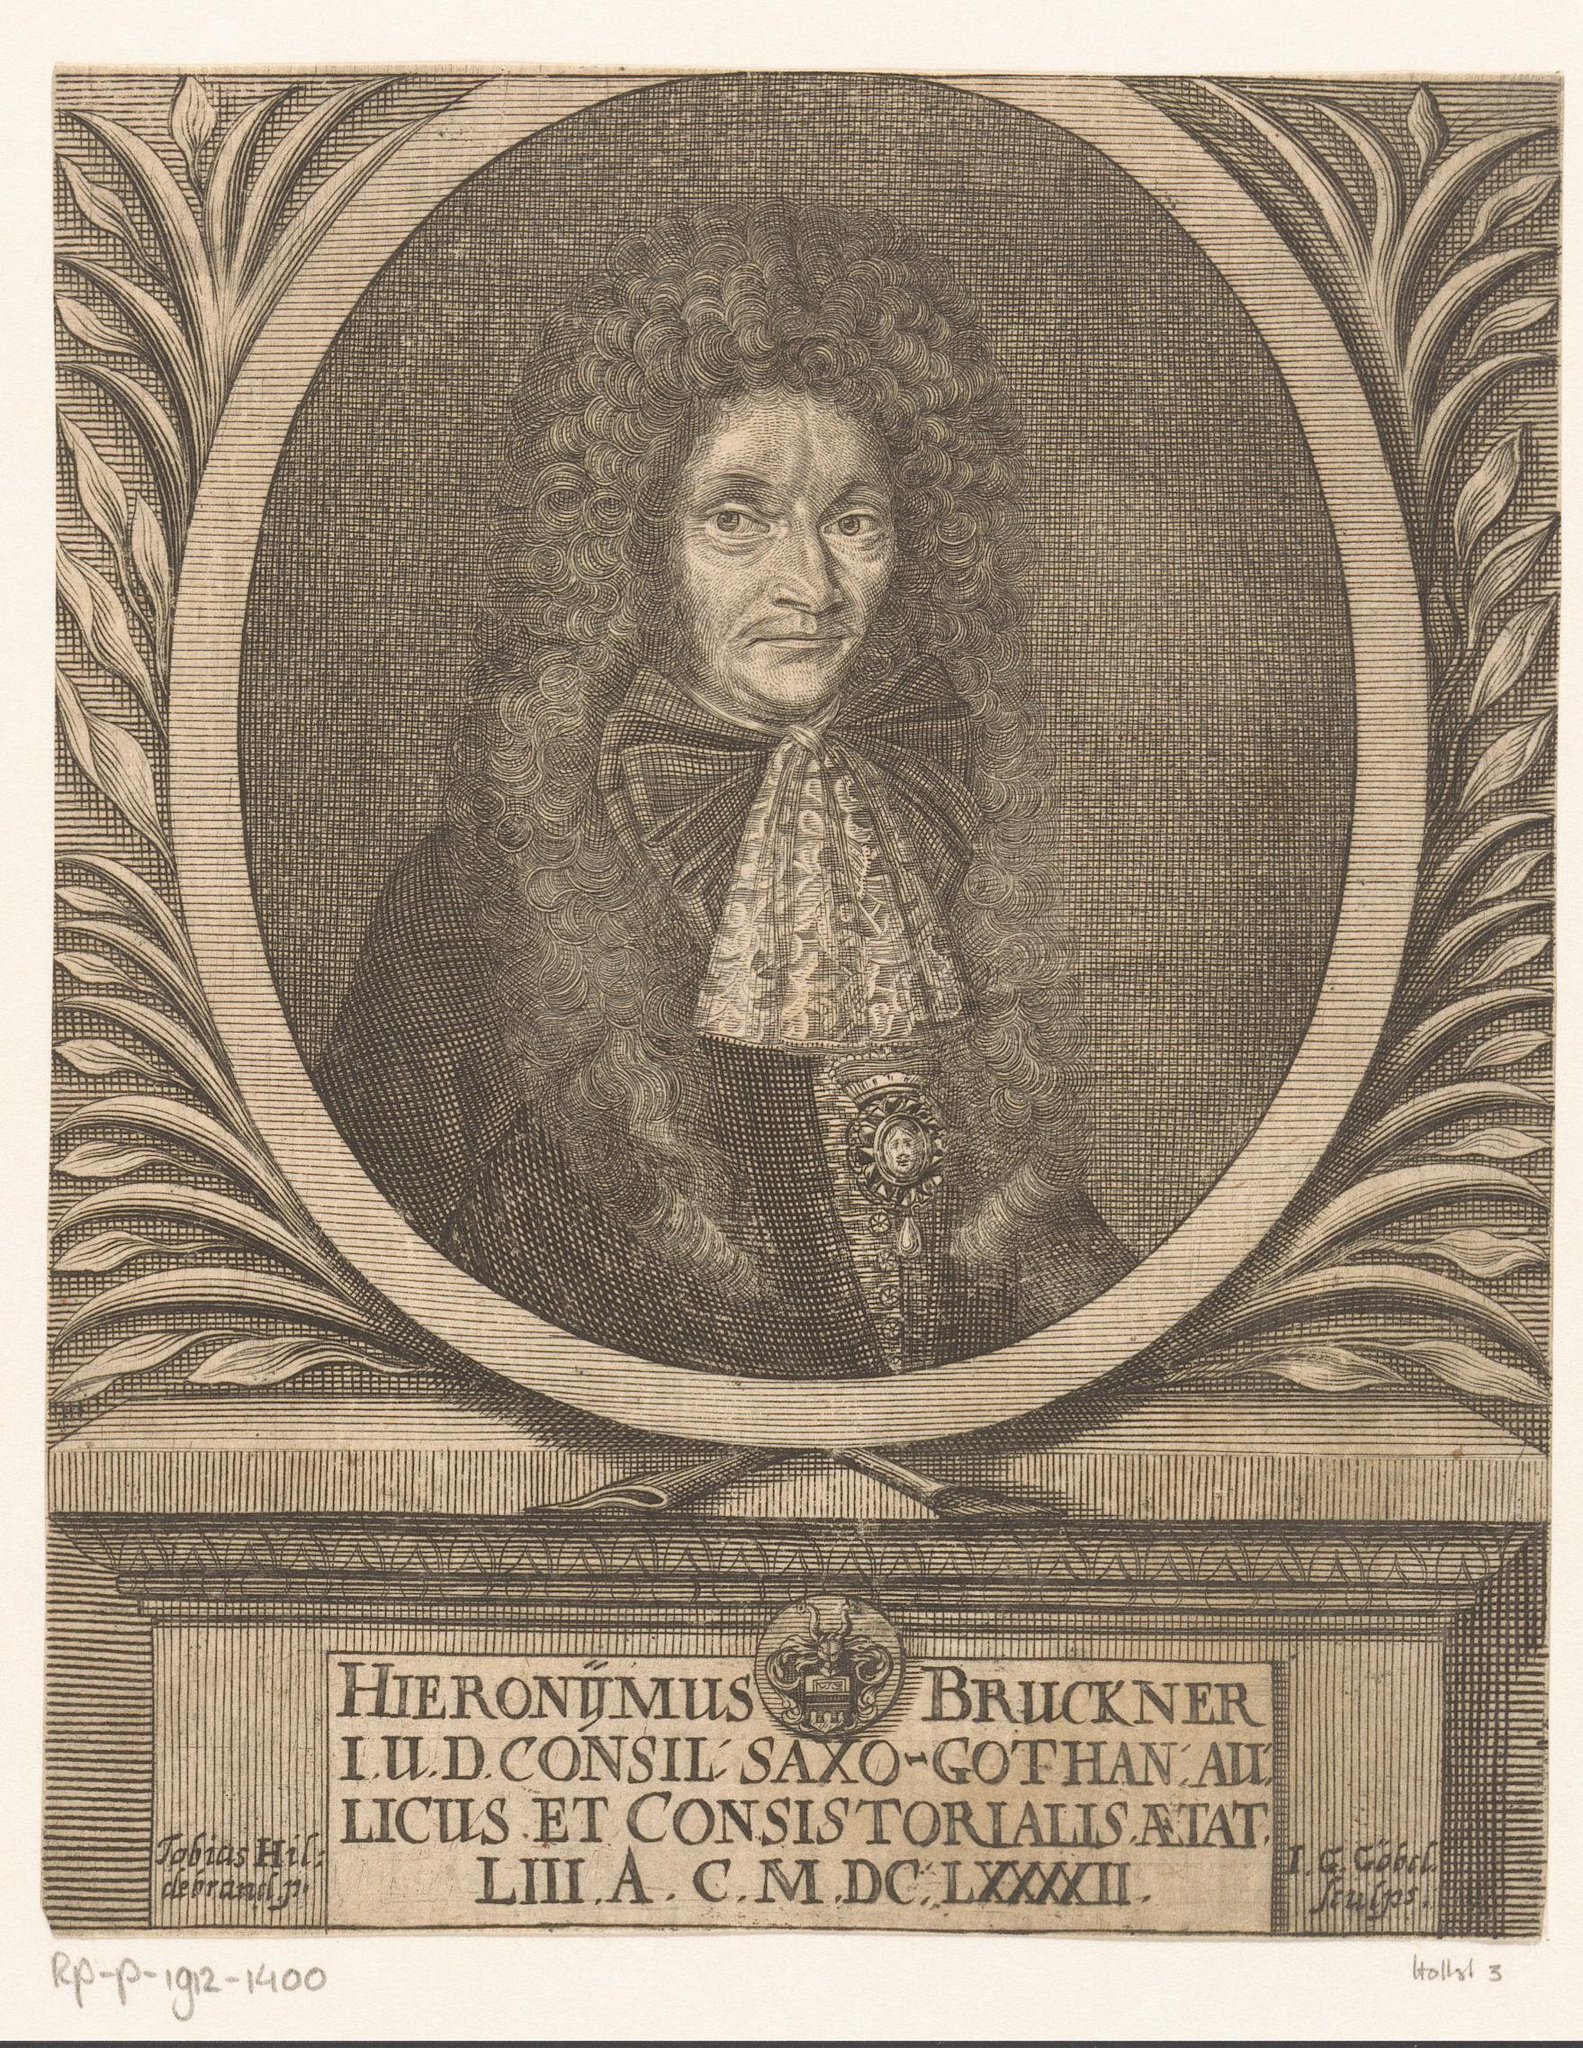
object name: print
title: Portret van Hieronymus Brückner op 53-jarige leeftijd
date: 1692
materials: paper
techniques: engraving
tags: trees: palm-tree (+ branch, stick), historical persons, pendant, trinket, 'breloque', armorial bearing, heraldry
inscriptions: collector's mark: Lugt 2228